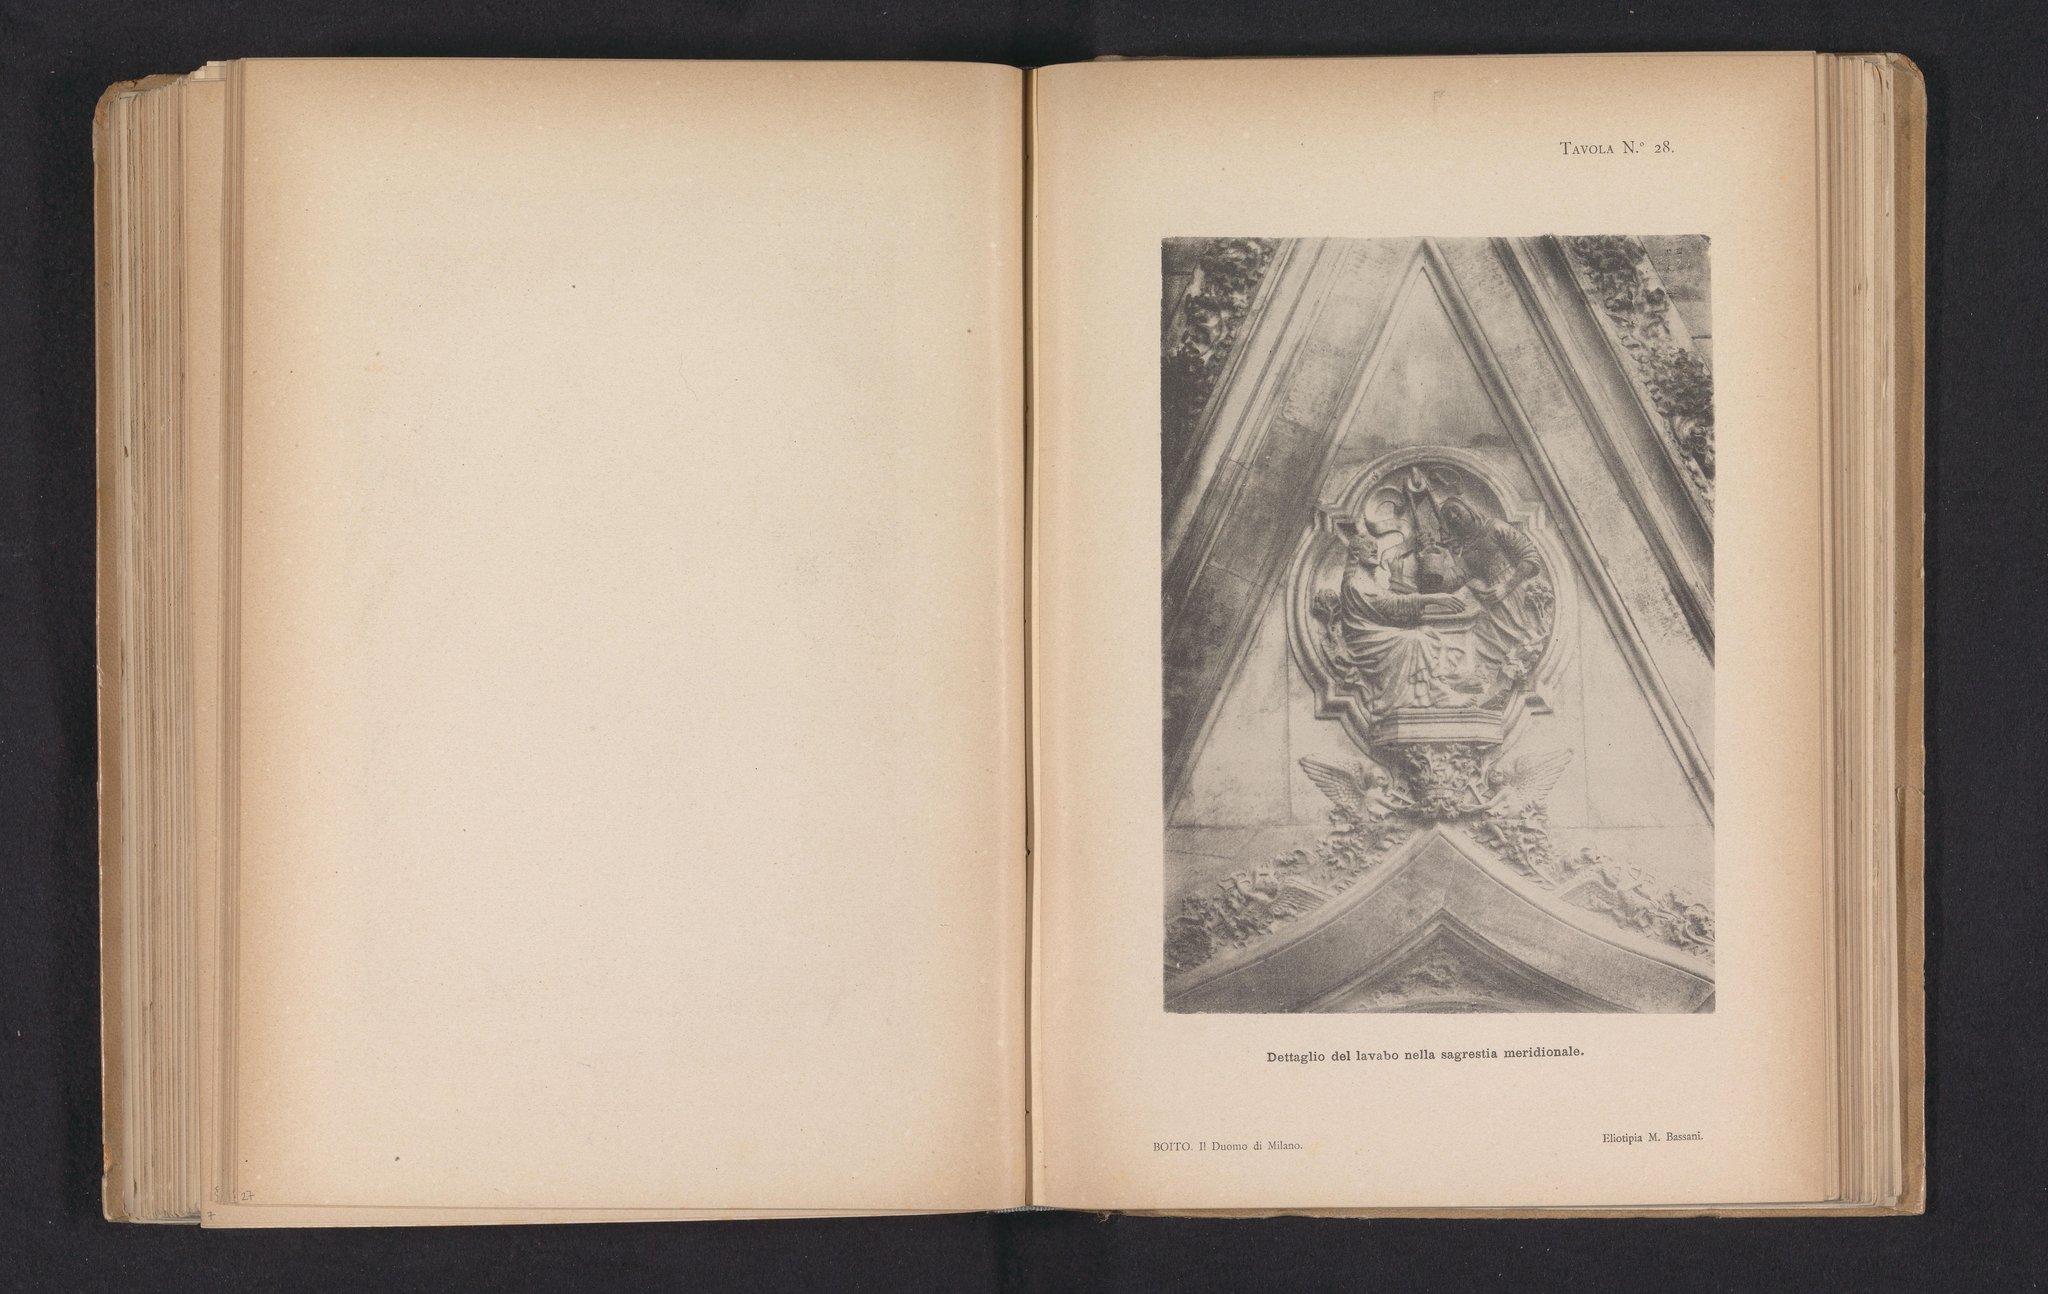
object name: photomechanical print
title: Dettaglio del lavabo nella sagrestia meridionale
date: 1879-1889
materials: paper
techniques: photograph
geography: milan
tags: sink, basin, parts of church interior: sacristy, decorating 'en relief', appliquéing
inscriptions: number: ‘Tavola No. 28.’